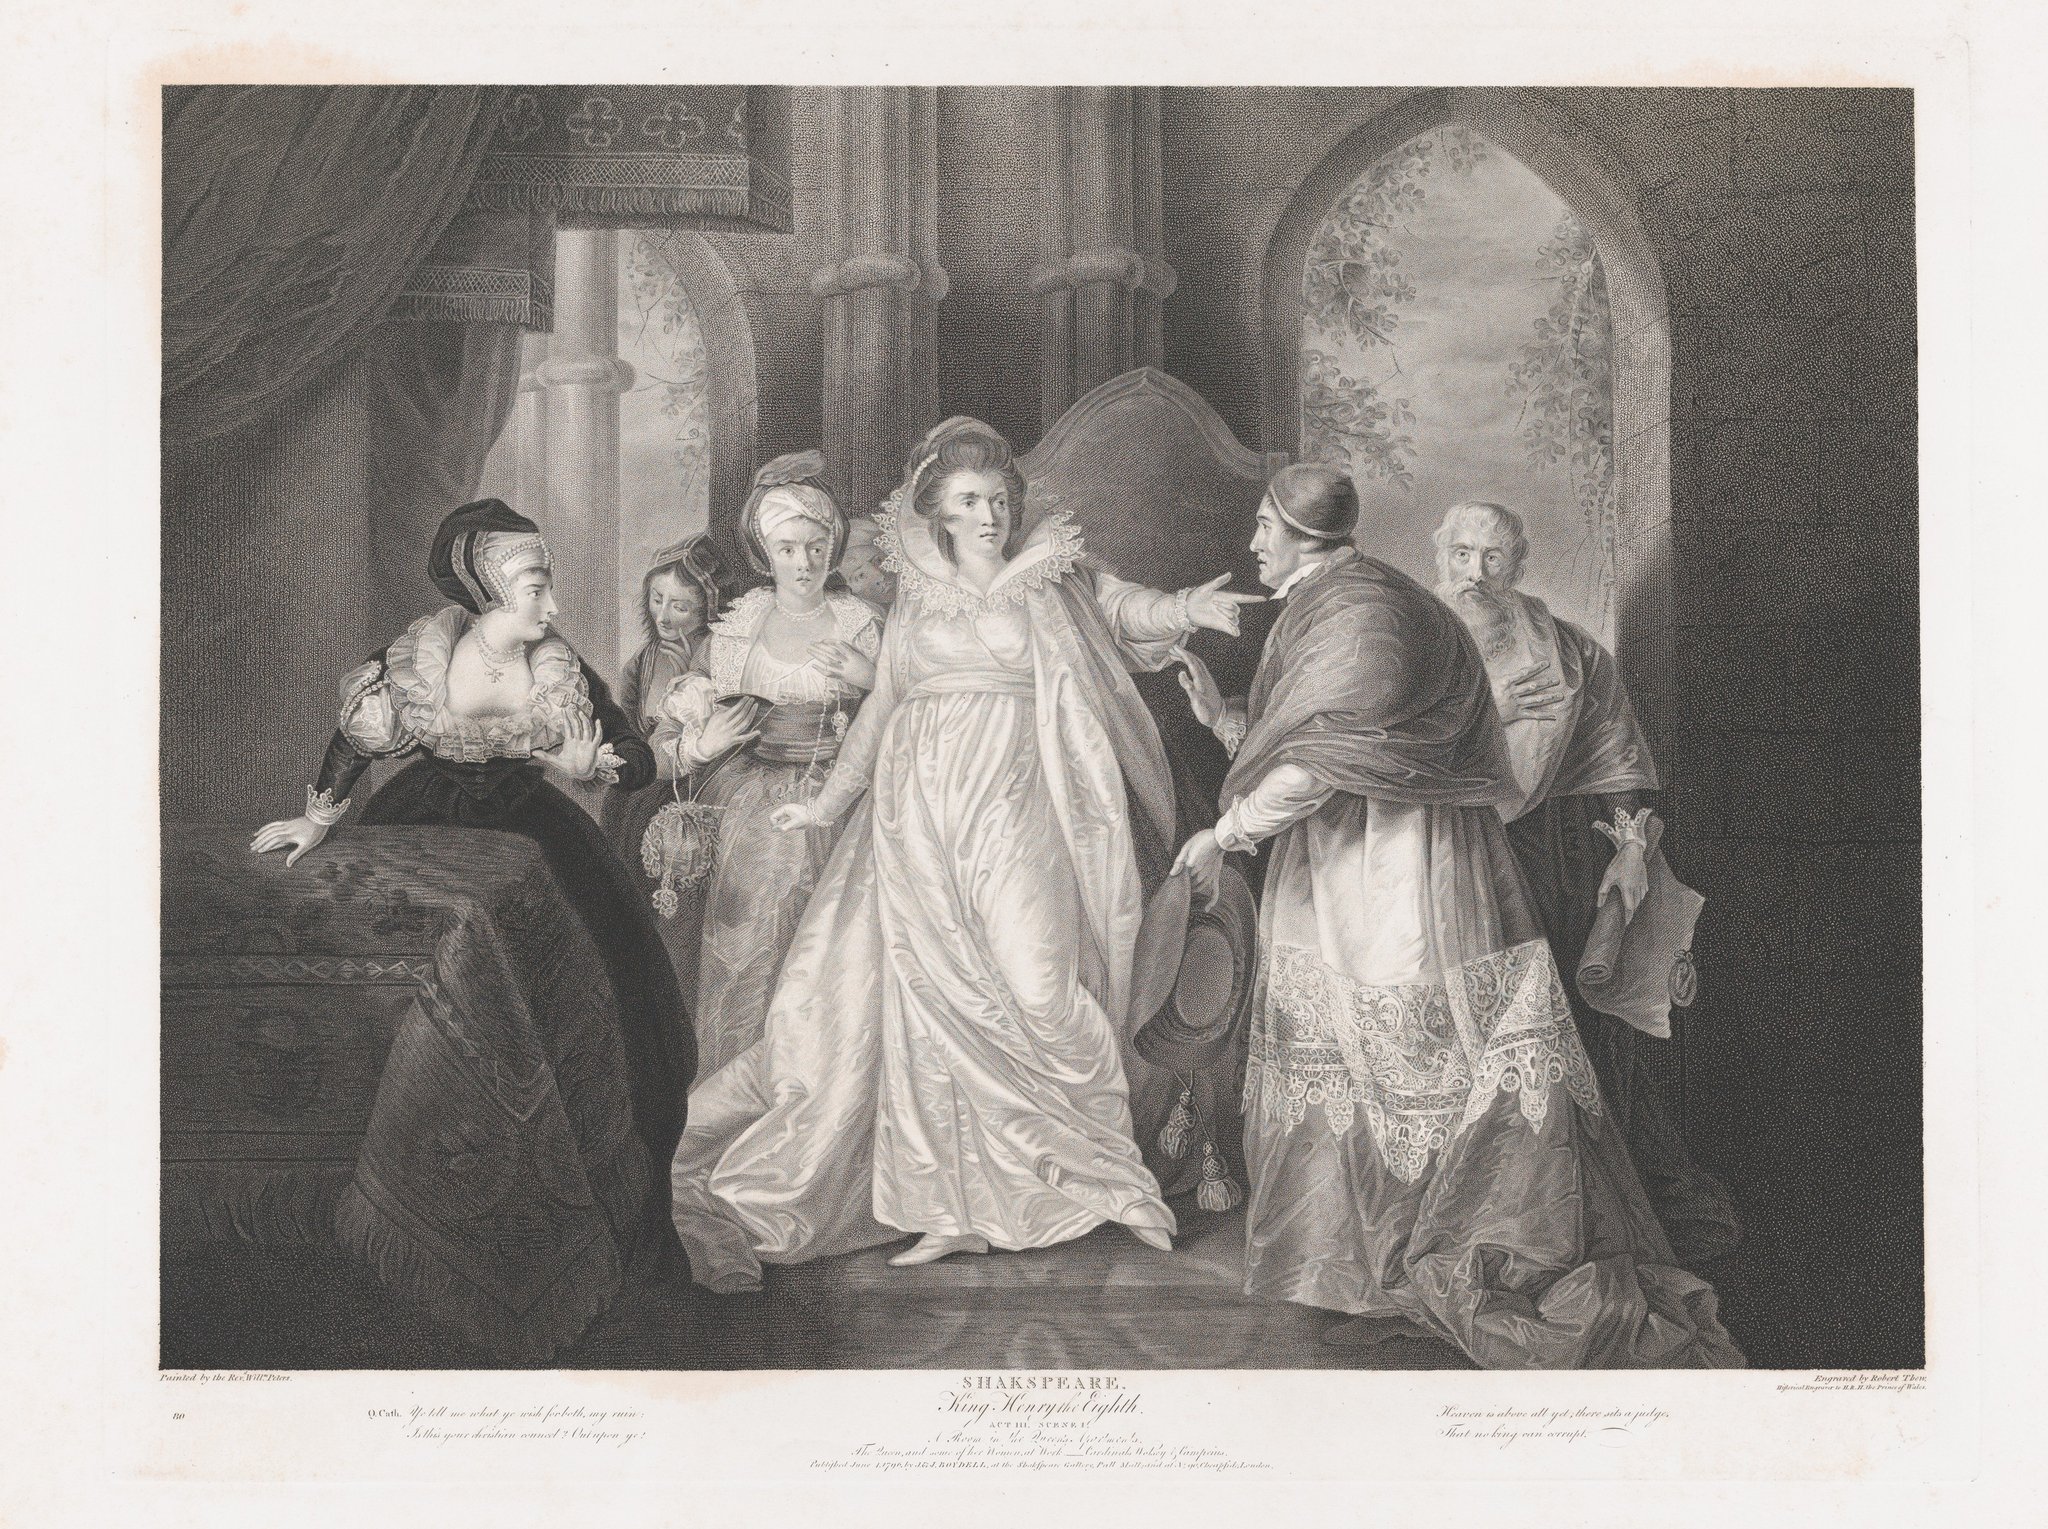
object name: print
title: Queen Catherine, Cardinal Wolsey and Cardinal Campeius (Shakespeare, King Henry VIII, Act 3, Scene 1)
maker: robert thew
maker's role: engraver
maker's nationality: british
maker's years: 1758-1802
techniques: engraving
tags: queens,shakespeare,men,women